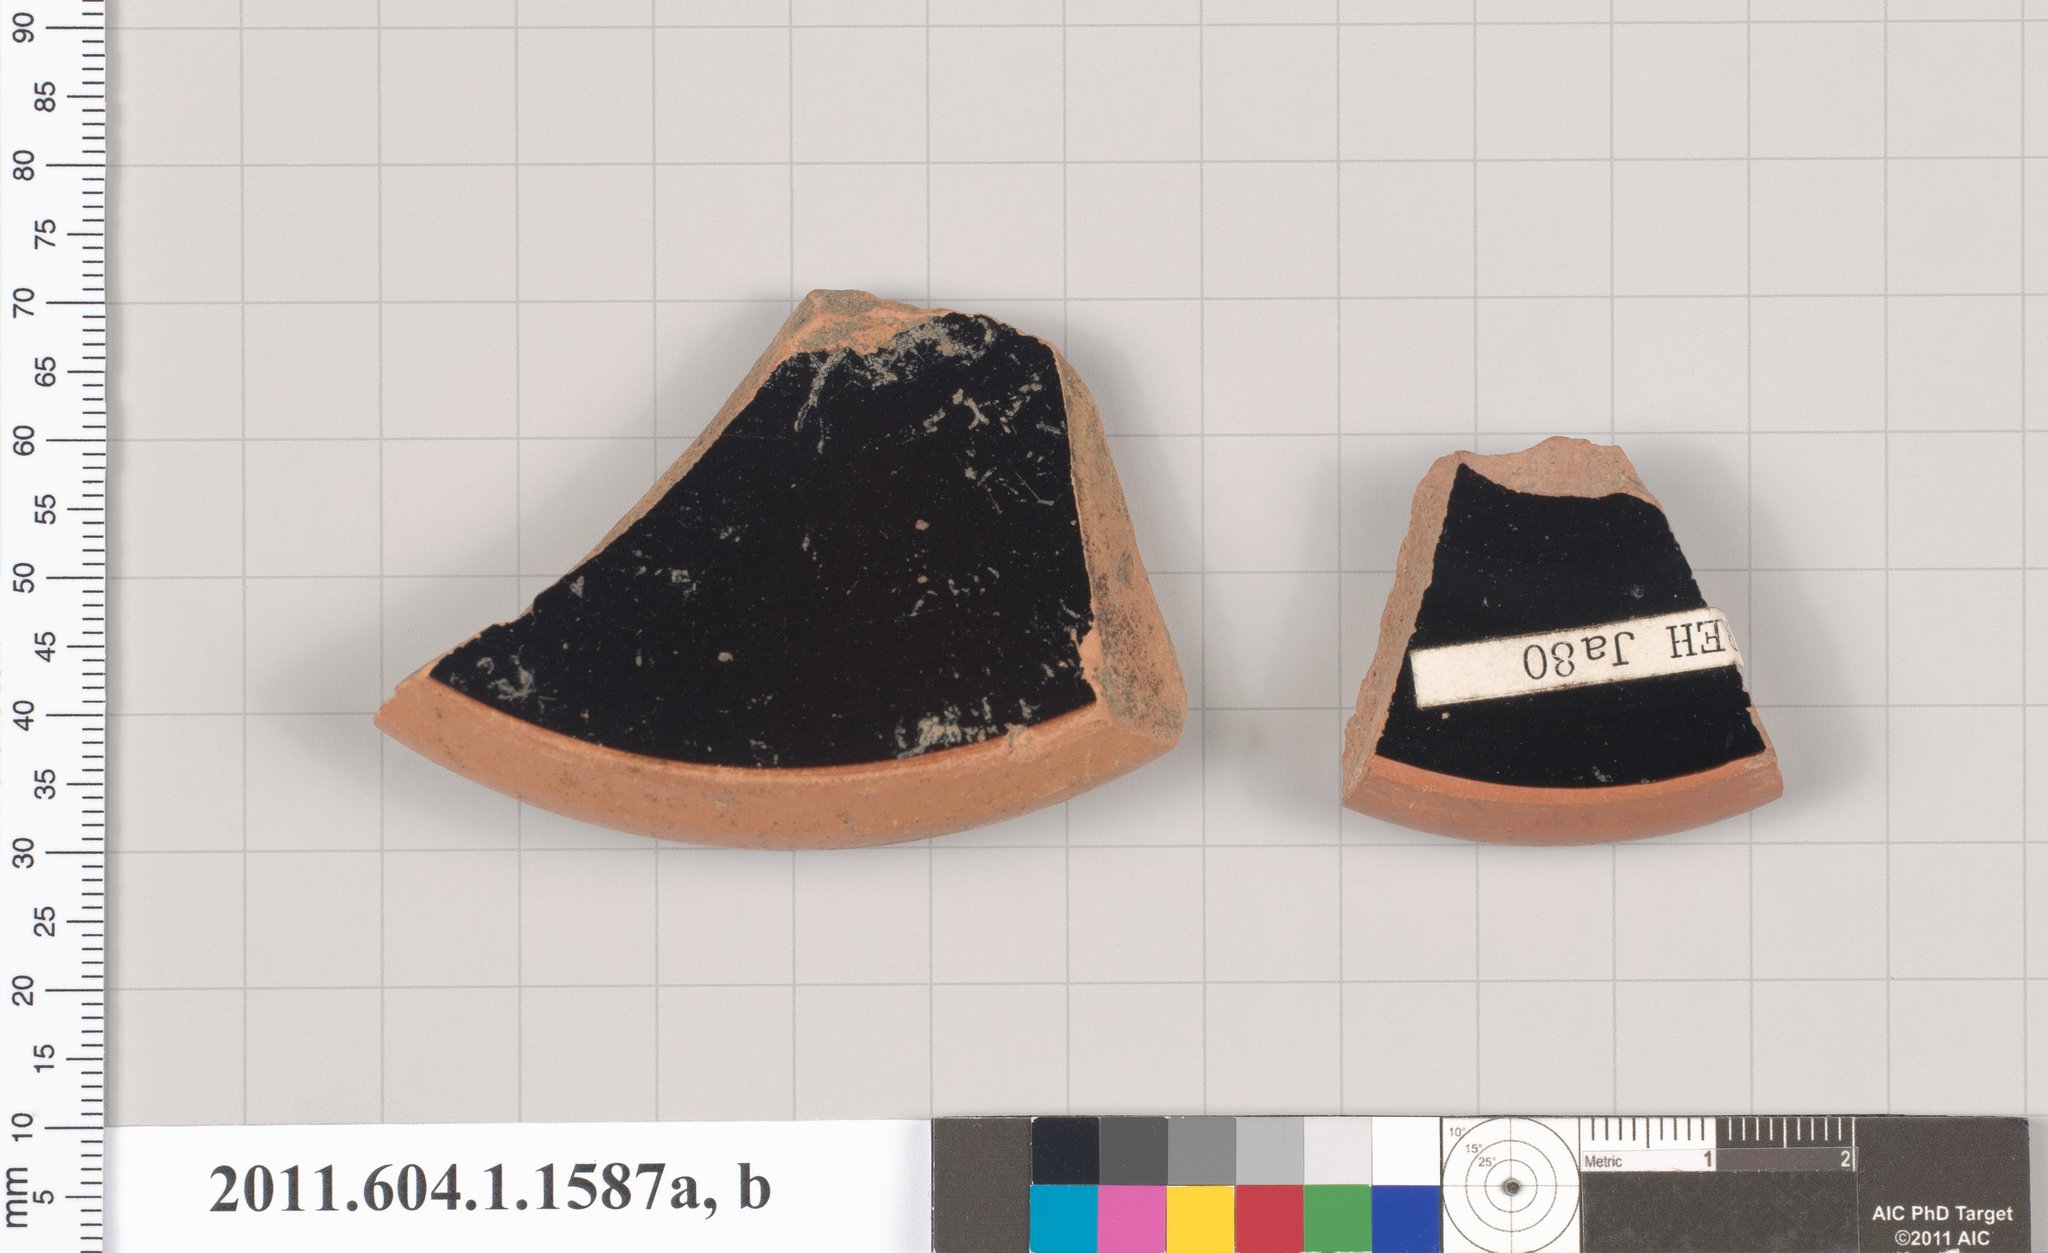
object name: kylix fragment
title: Terracotta fragments of kylikes (drinking cups)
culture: greek, attic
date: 500-401 BCE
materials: terracotta